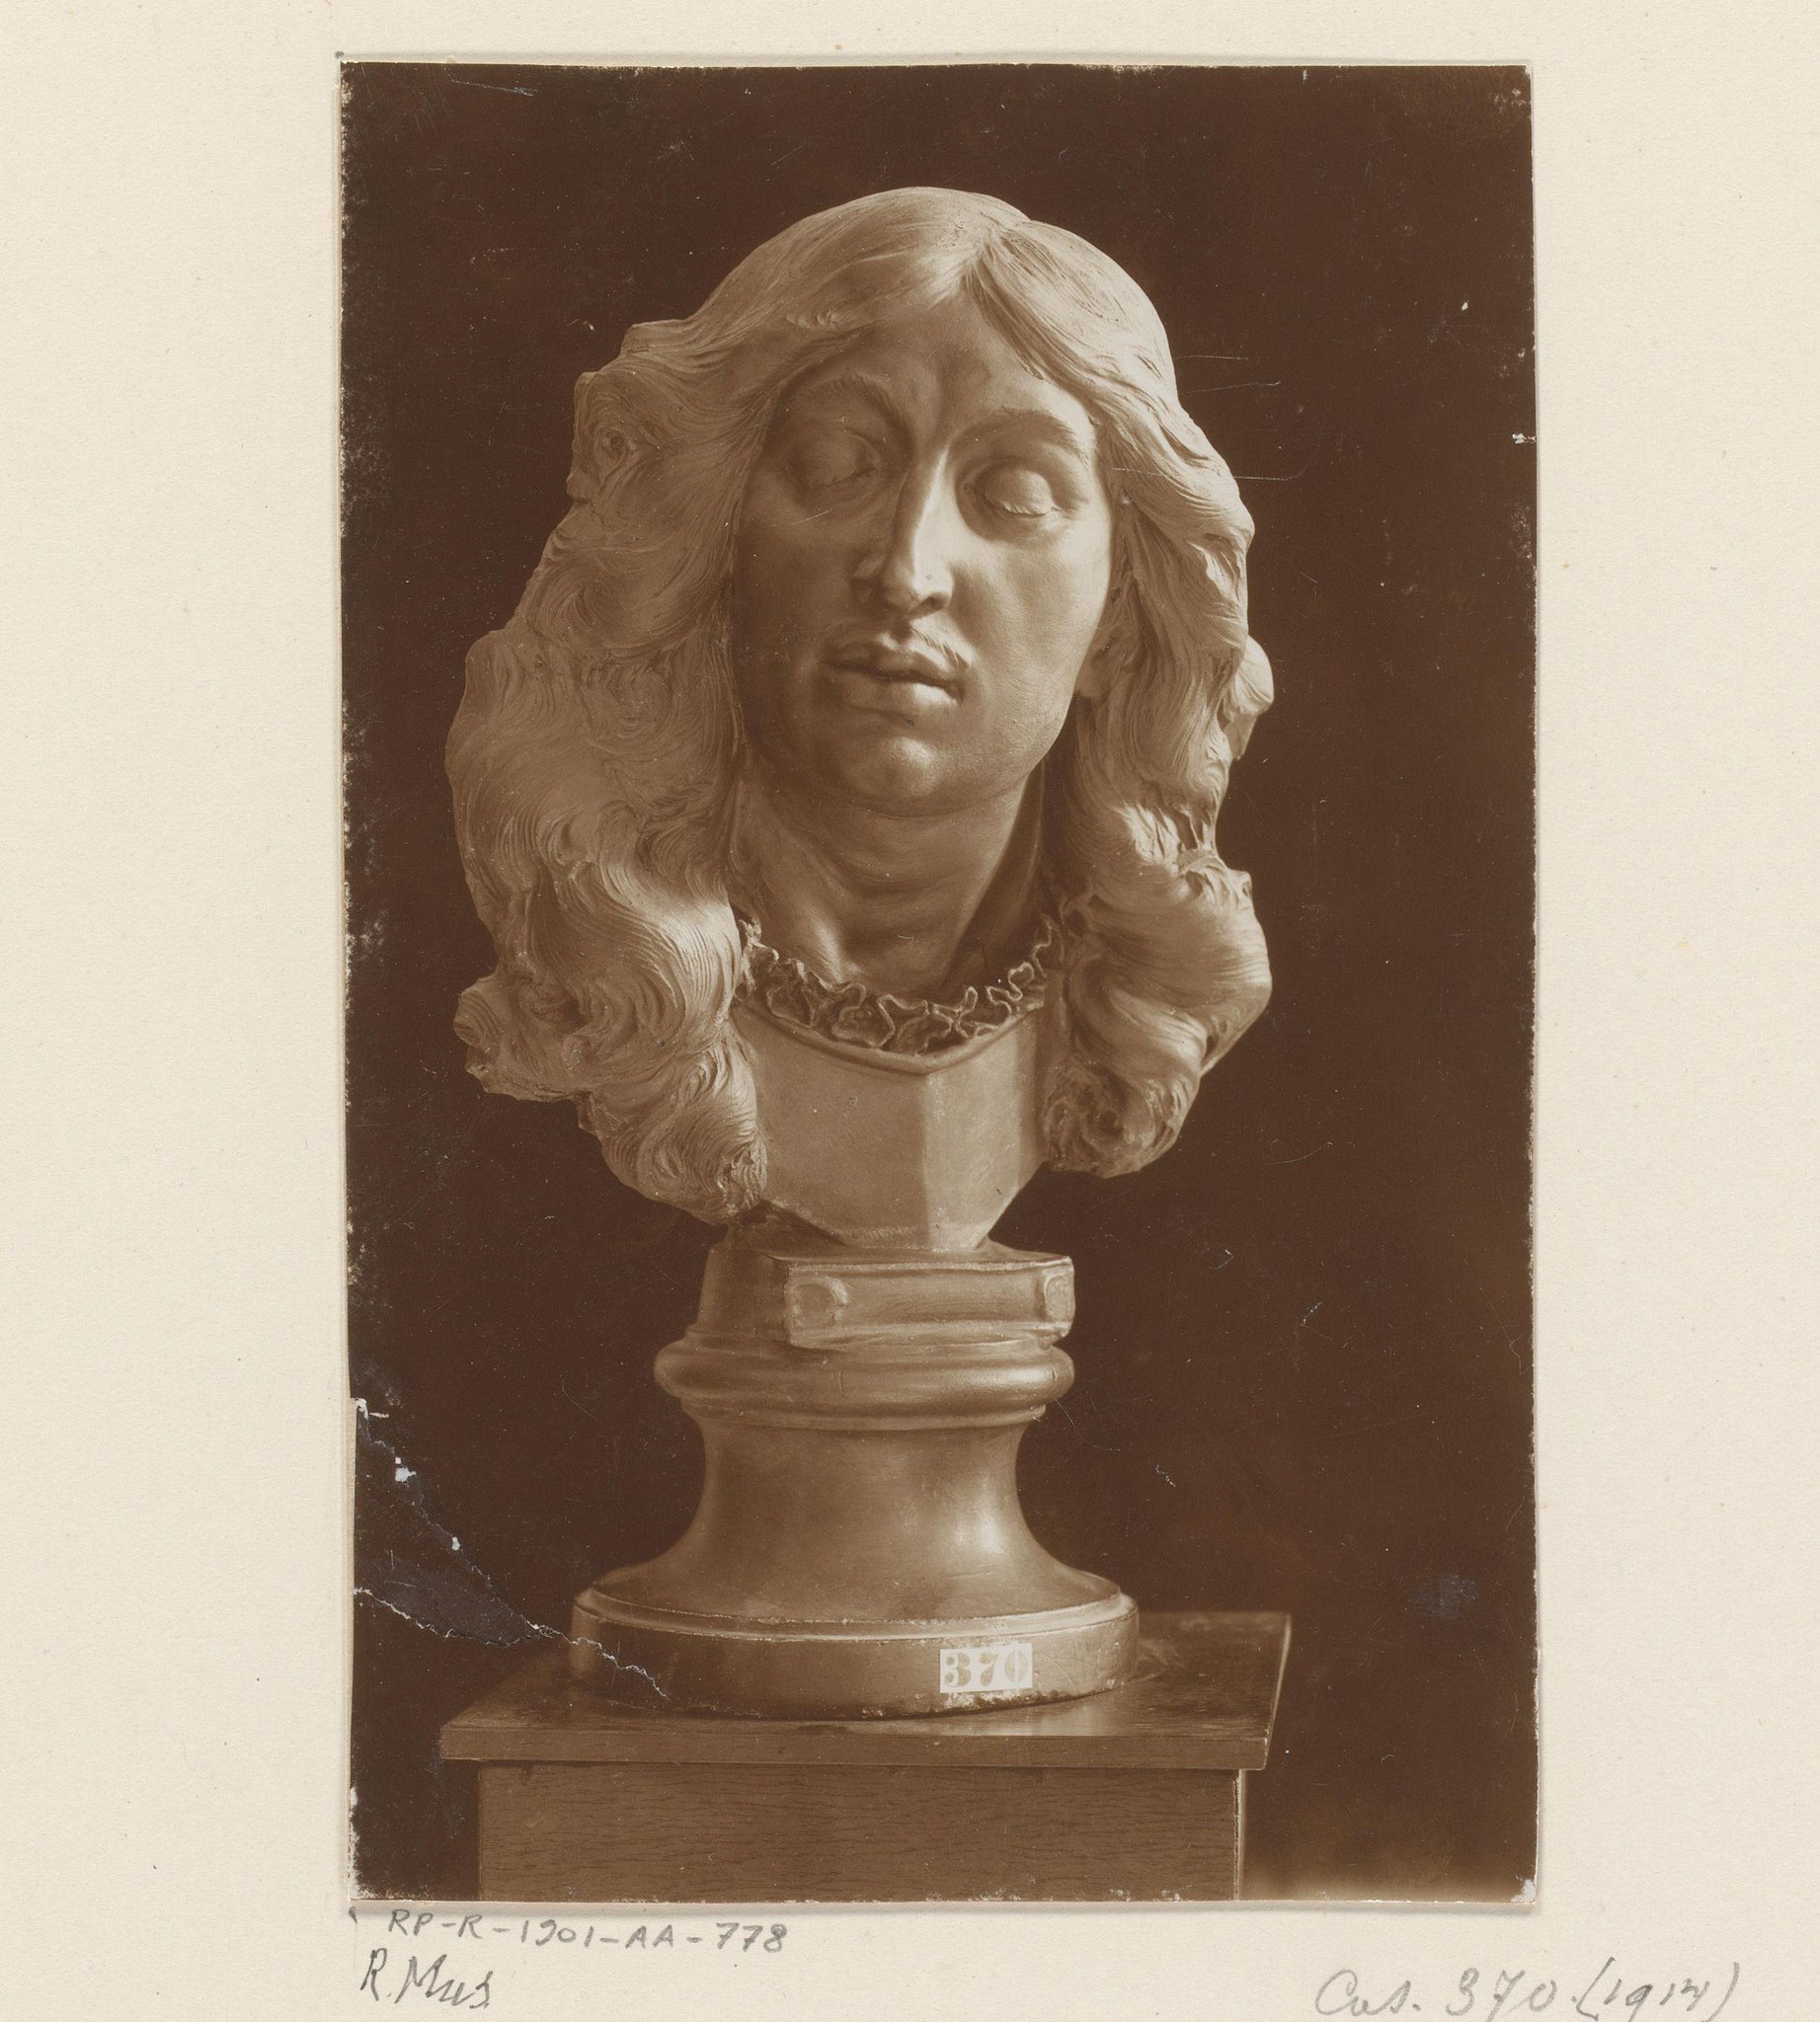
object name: photograph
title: Doodsportret van admiraal Willem Joseph (1625-1672), baron van Gendt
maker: Anonymous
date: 1890-1901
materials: paper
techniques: collodion silver print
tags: willem joseph baron van gendt, historical persons, piece of sculpture, reproduction of a piece of sculpture